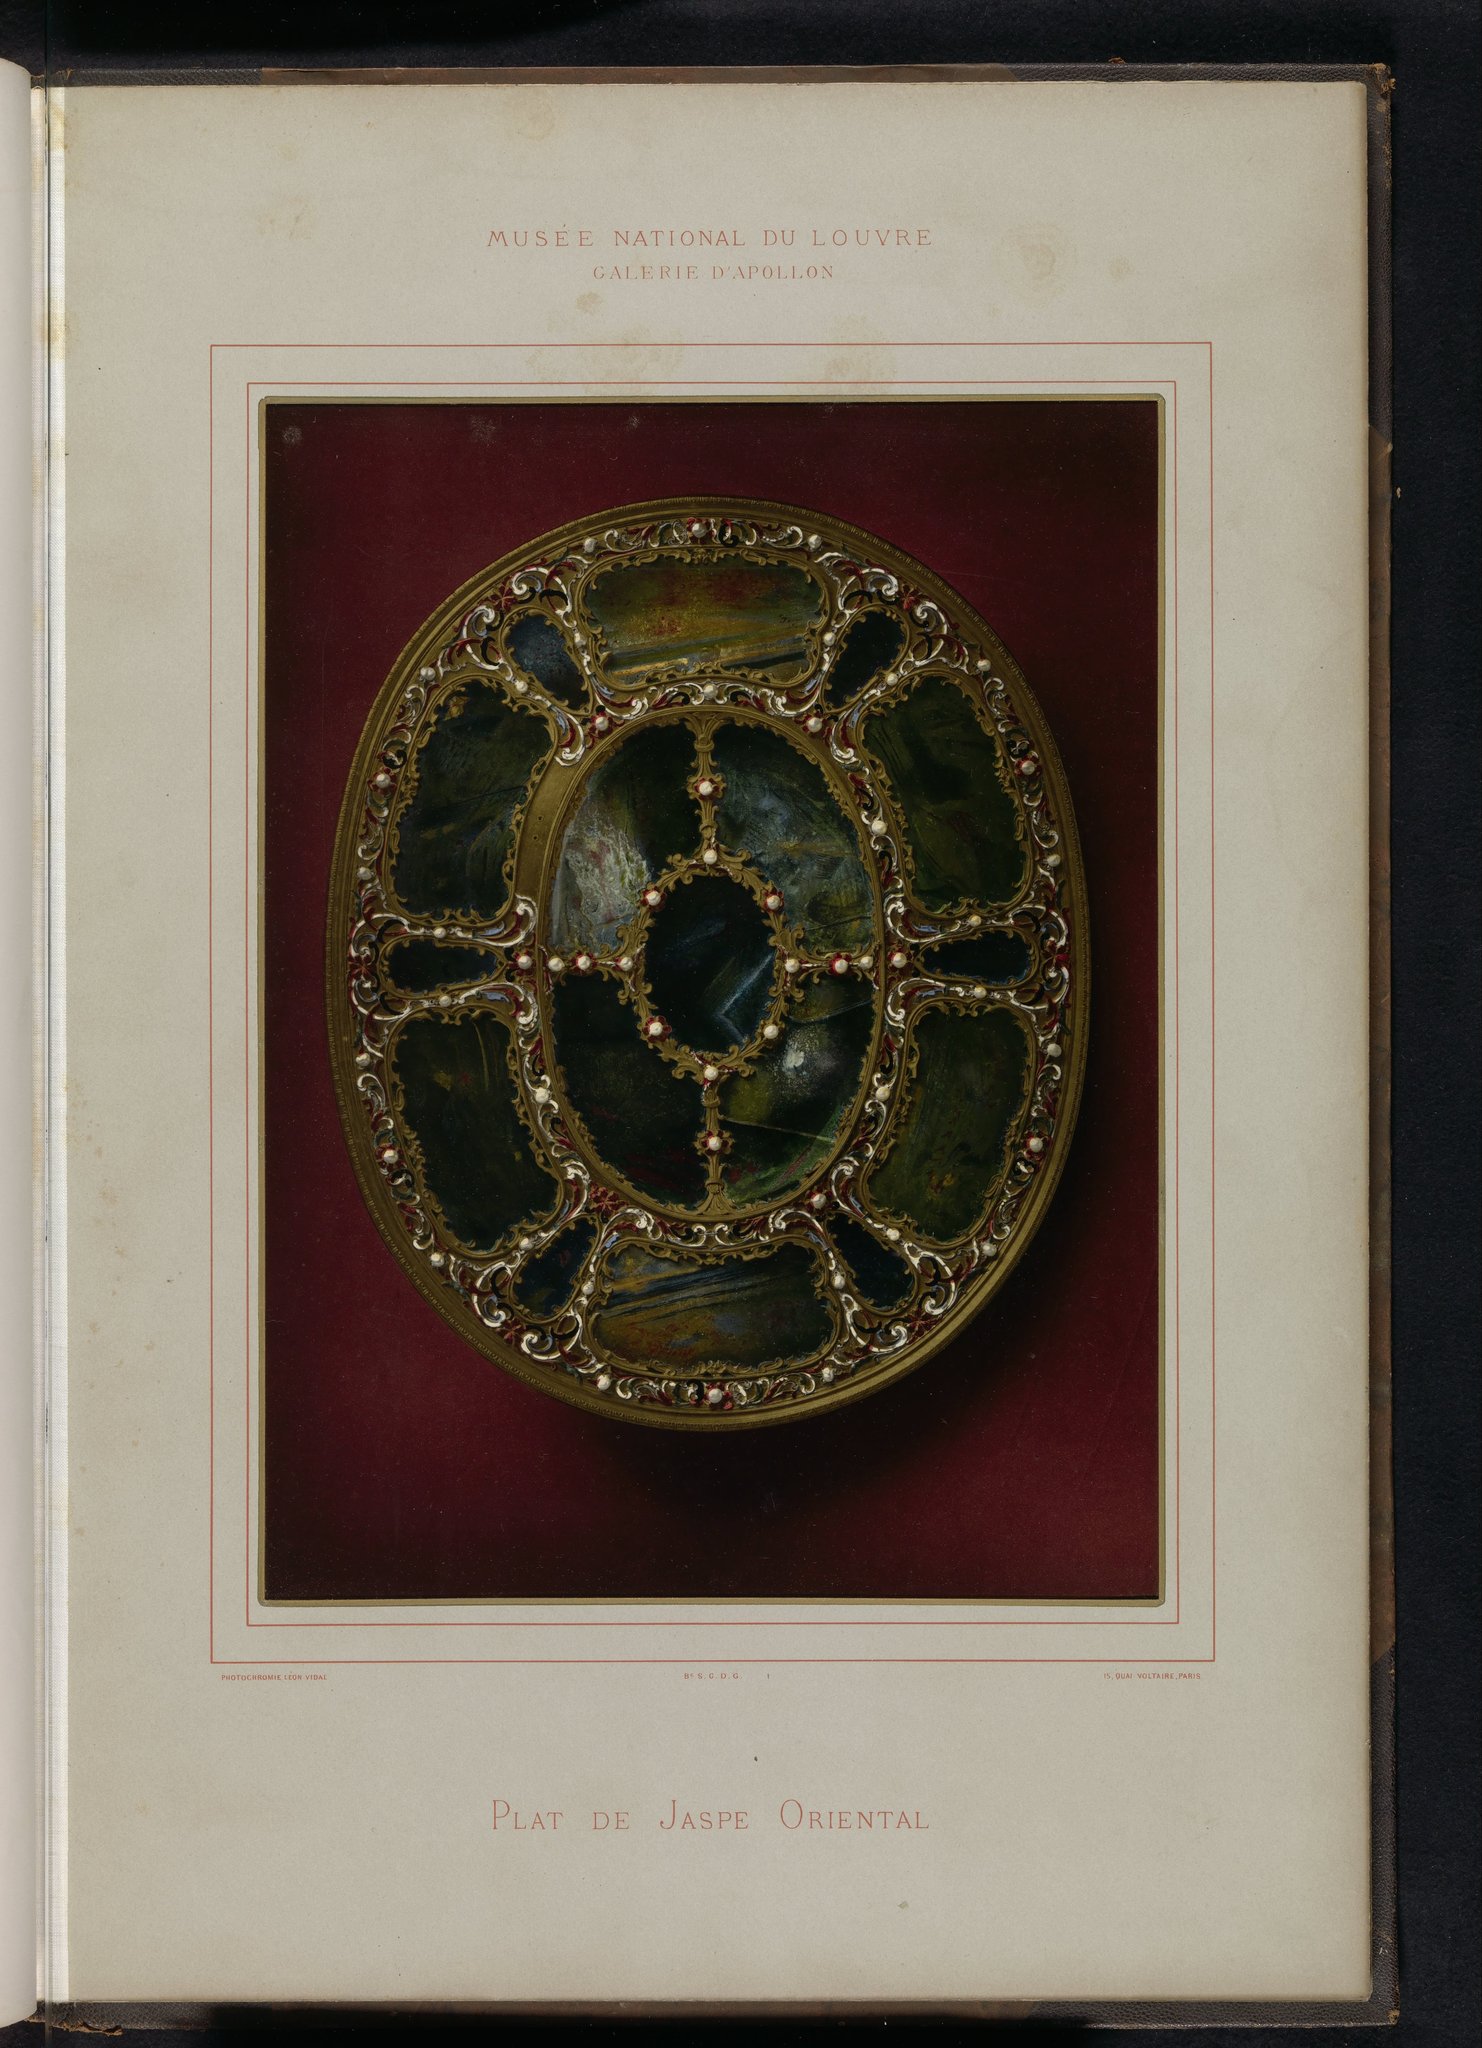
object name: page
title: Plat de Jaspe Oriental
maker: léon vidal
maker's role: fotograaf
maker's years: 1833-1906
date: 1876-1883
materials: paper, photographic process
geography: paris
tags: precious and semiprecious stones: jasper, dish, plate, saucer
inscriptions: inscription: ‘[...]0e livraison’, inscription: ‘Musée National du Louvre Galerie d'Apollon’, inscription: ‘15 Quai Voltaire. Paris.’